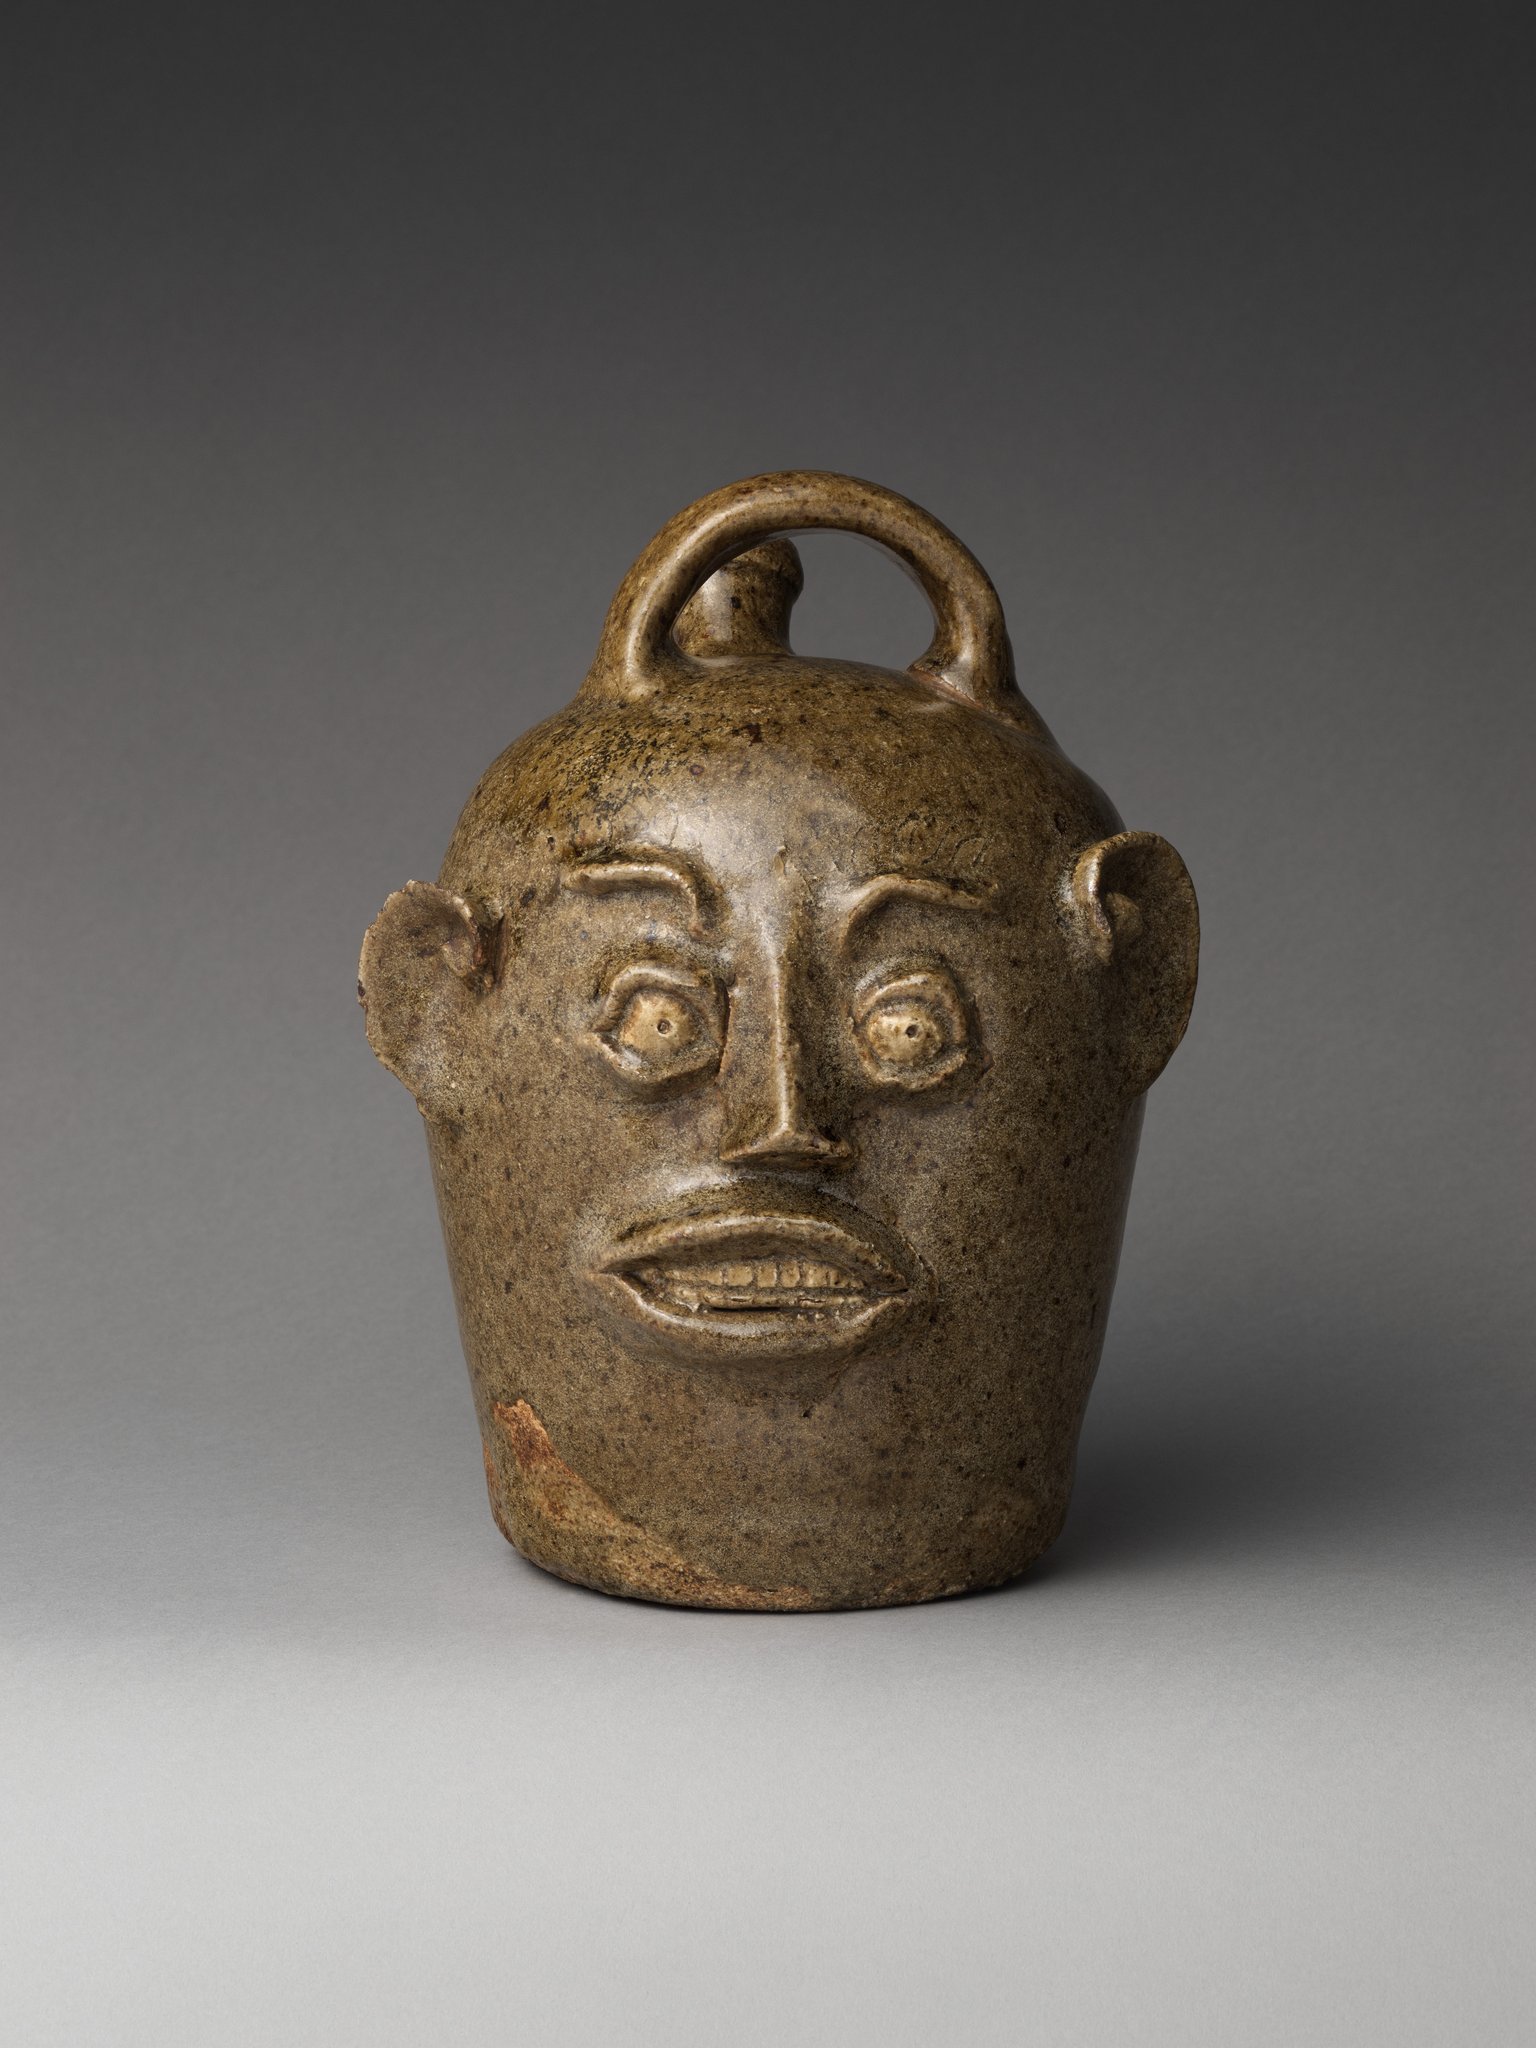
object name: face jug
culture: american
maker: unrecorded edgefield district potter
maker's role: maker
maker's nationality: american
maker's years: 1800-1920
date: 1850-1880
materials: stoneware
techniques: glazing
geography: united states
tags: faces